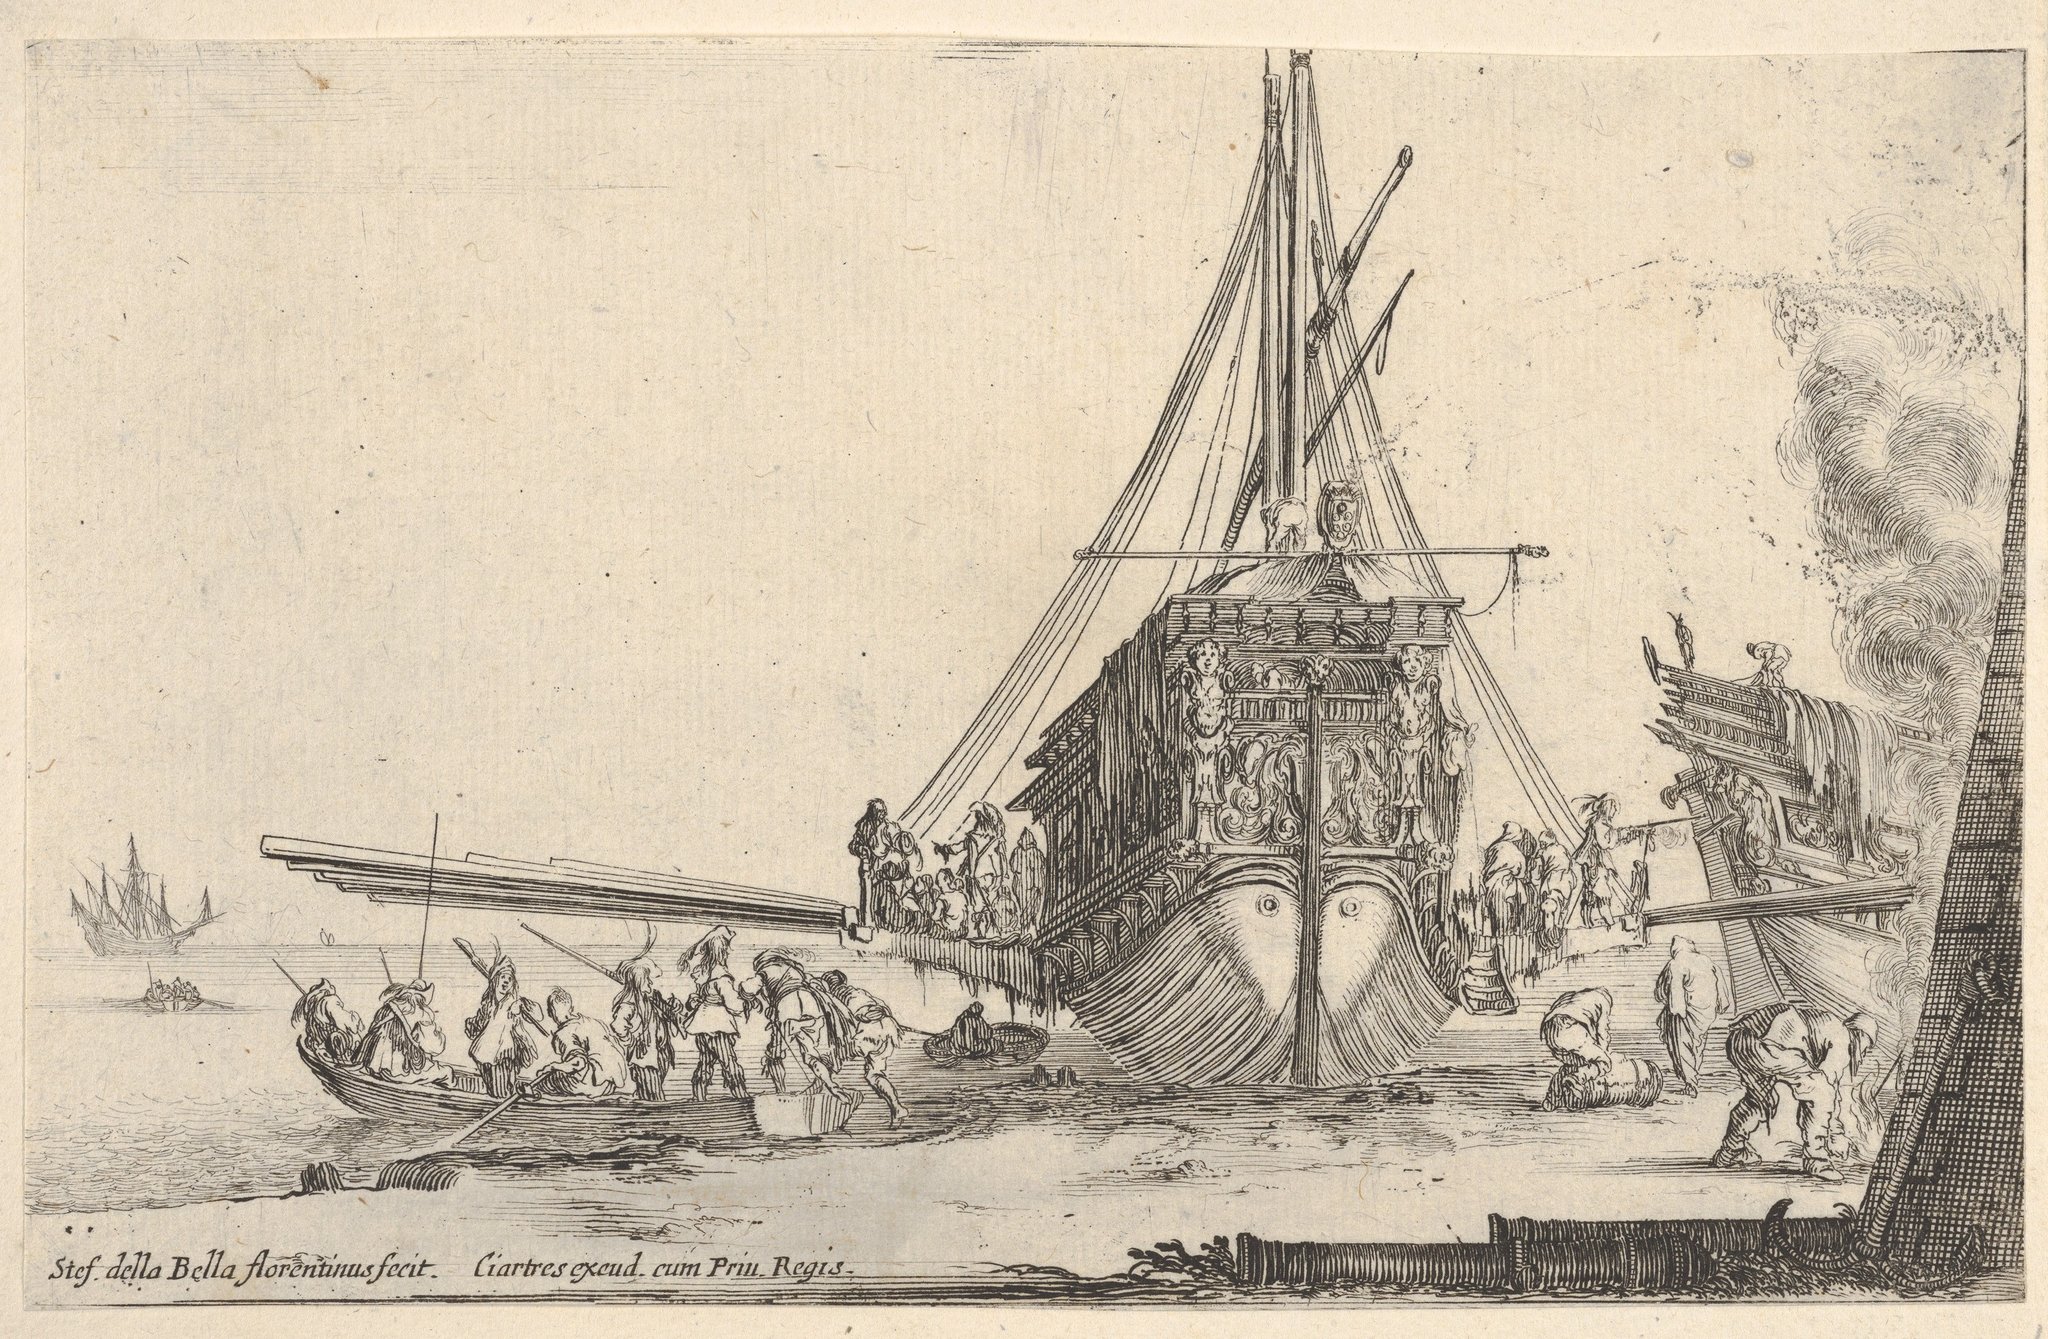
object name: print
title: A galley embarking at center, seen from behind, the stern of another galley to right under a fire, eight men in a rowboat to left, from "Varie Figure"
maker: stefano della bella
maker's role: artist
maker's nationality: italian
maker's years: 1610-1664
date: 1645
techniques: etching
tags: boats,ships